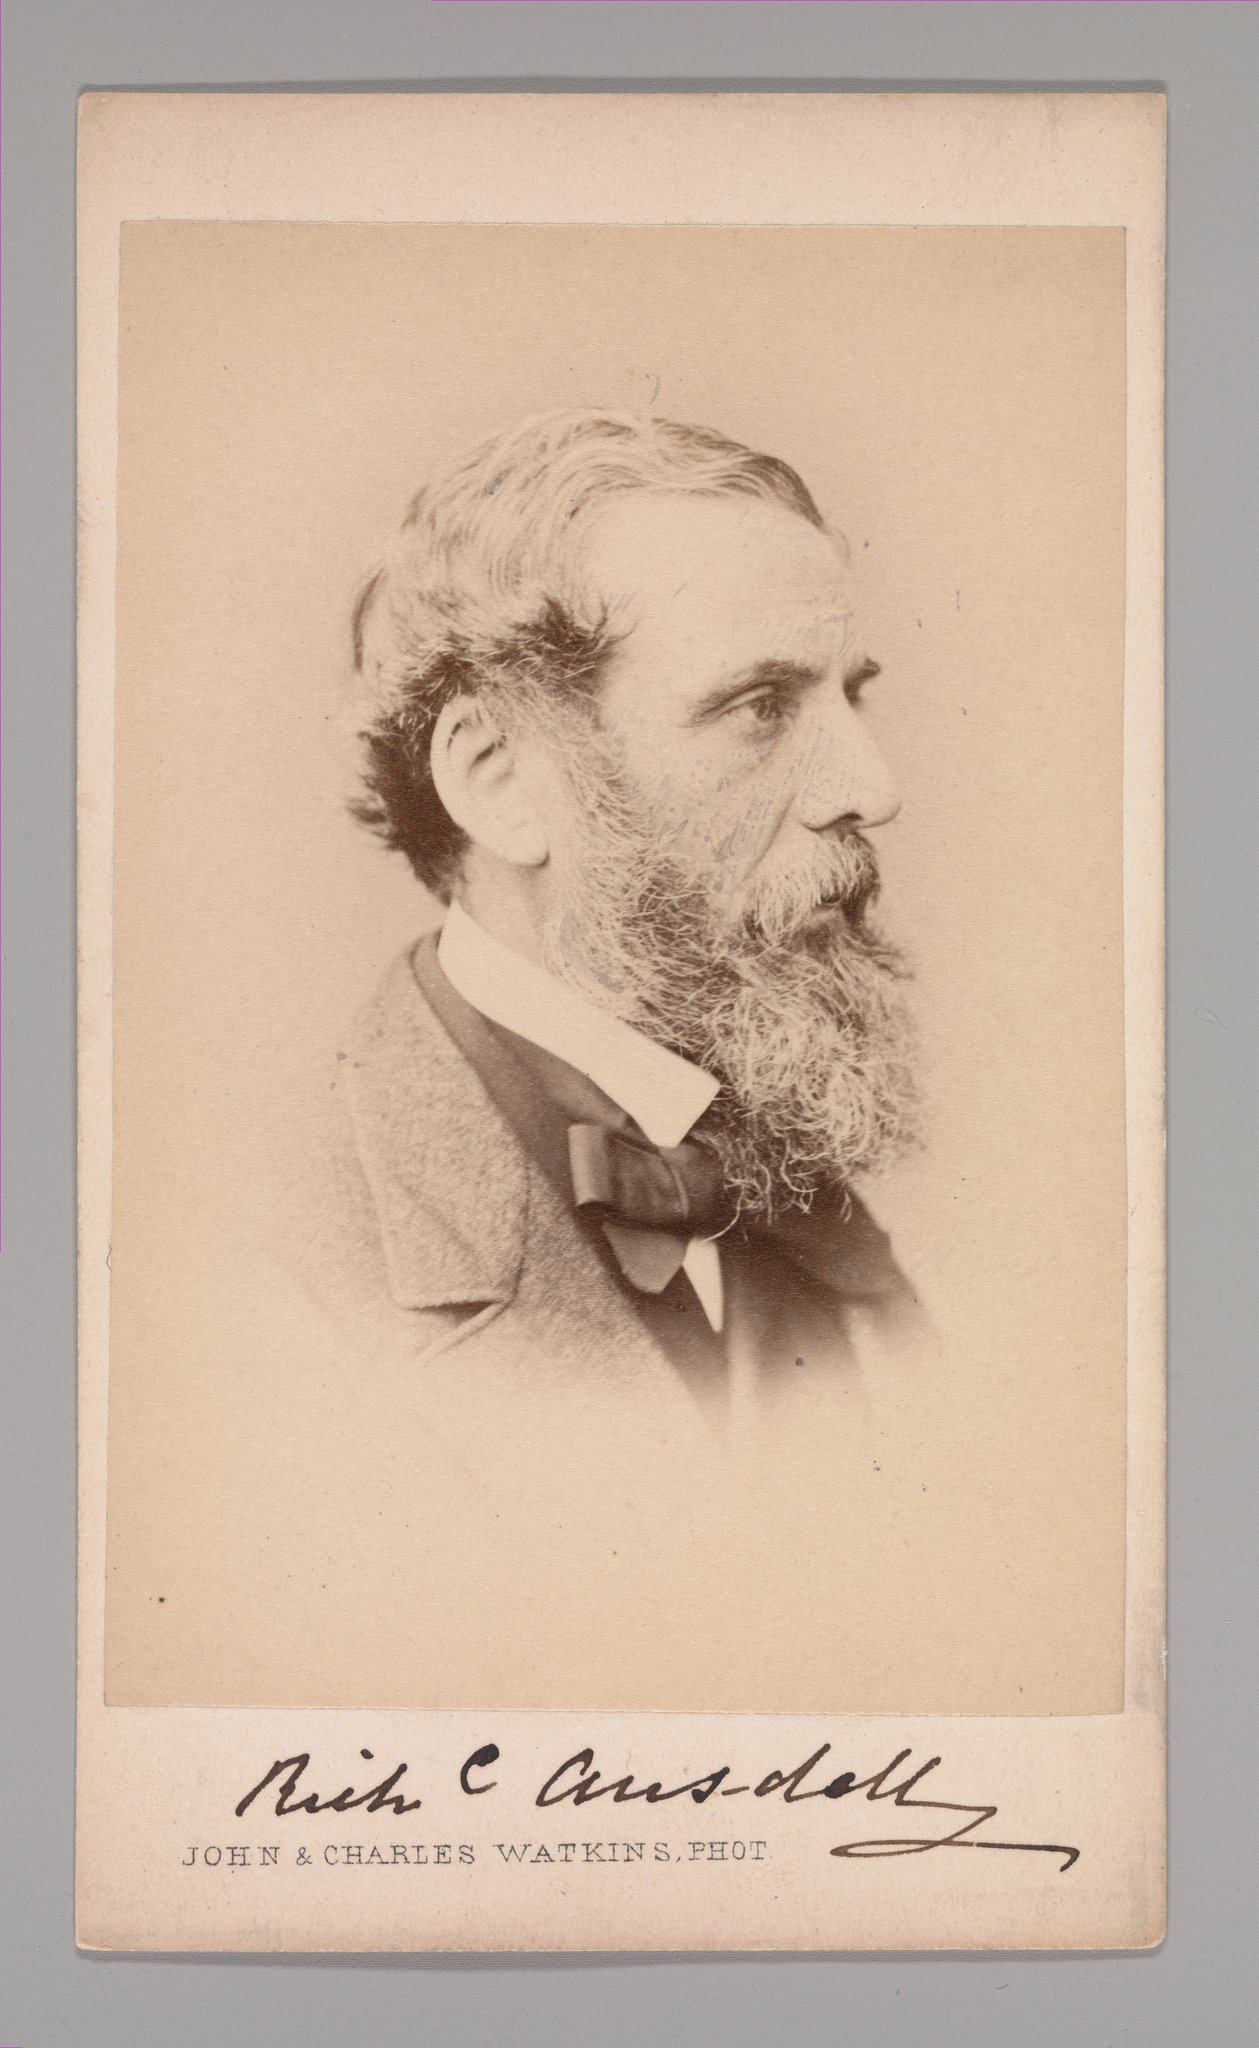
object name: carte de visite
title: [Richard Ansdell]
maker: john and charles watkins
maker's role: photography studio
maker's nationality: british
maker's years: 1840-1875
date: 1860-1869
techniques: albumen silver print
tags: men,portraits,profiles